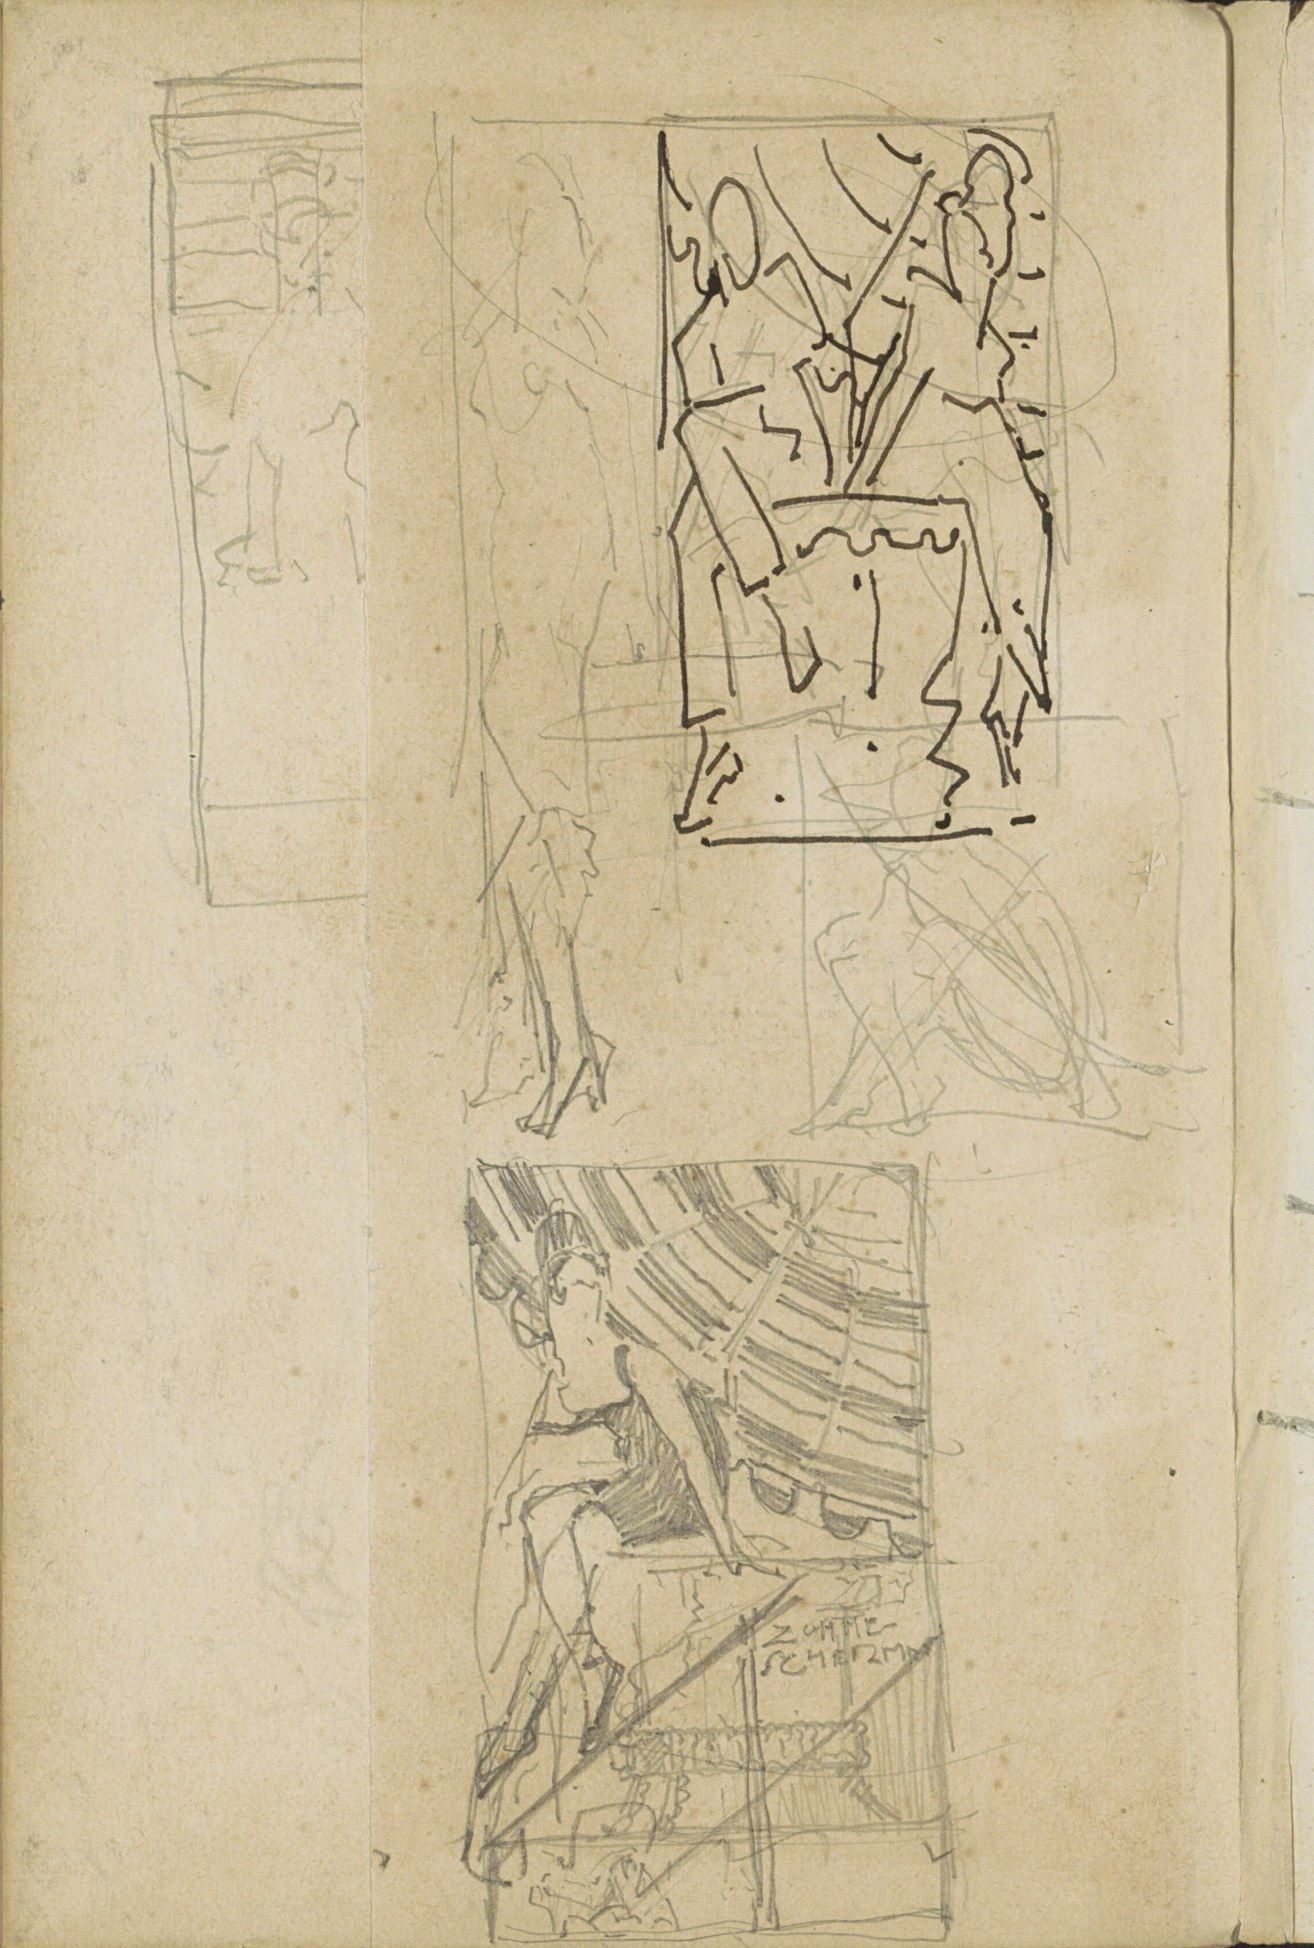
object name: sketchbook leaf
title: Reclameontwerpen voor zonneschermen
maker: reijer stolk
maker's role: draughtsman, print maker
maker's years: 1896-1945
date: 1908-1919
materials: ink, pencil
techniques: pen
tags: advertising, parasol, sunshade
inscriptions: annotation: ‘ZONNE-/ SCHERMEN’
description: De ontwerpen tonen een man en vrouw onder een parasol. Blad 33 verso uit een schetsboek met 33 bladen.